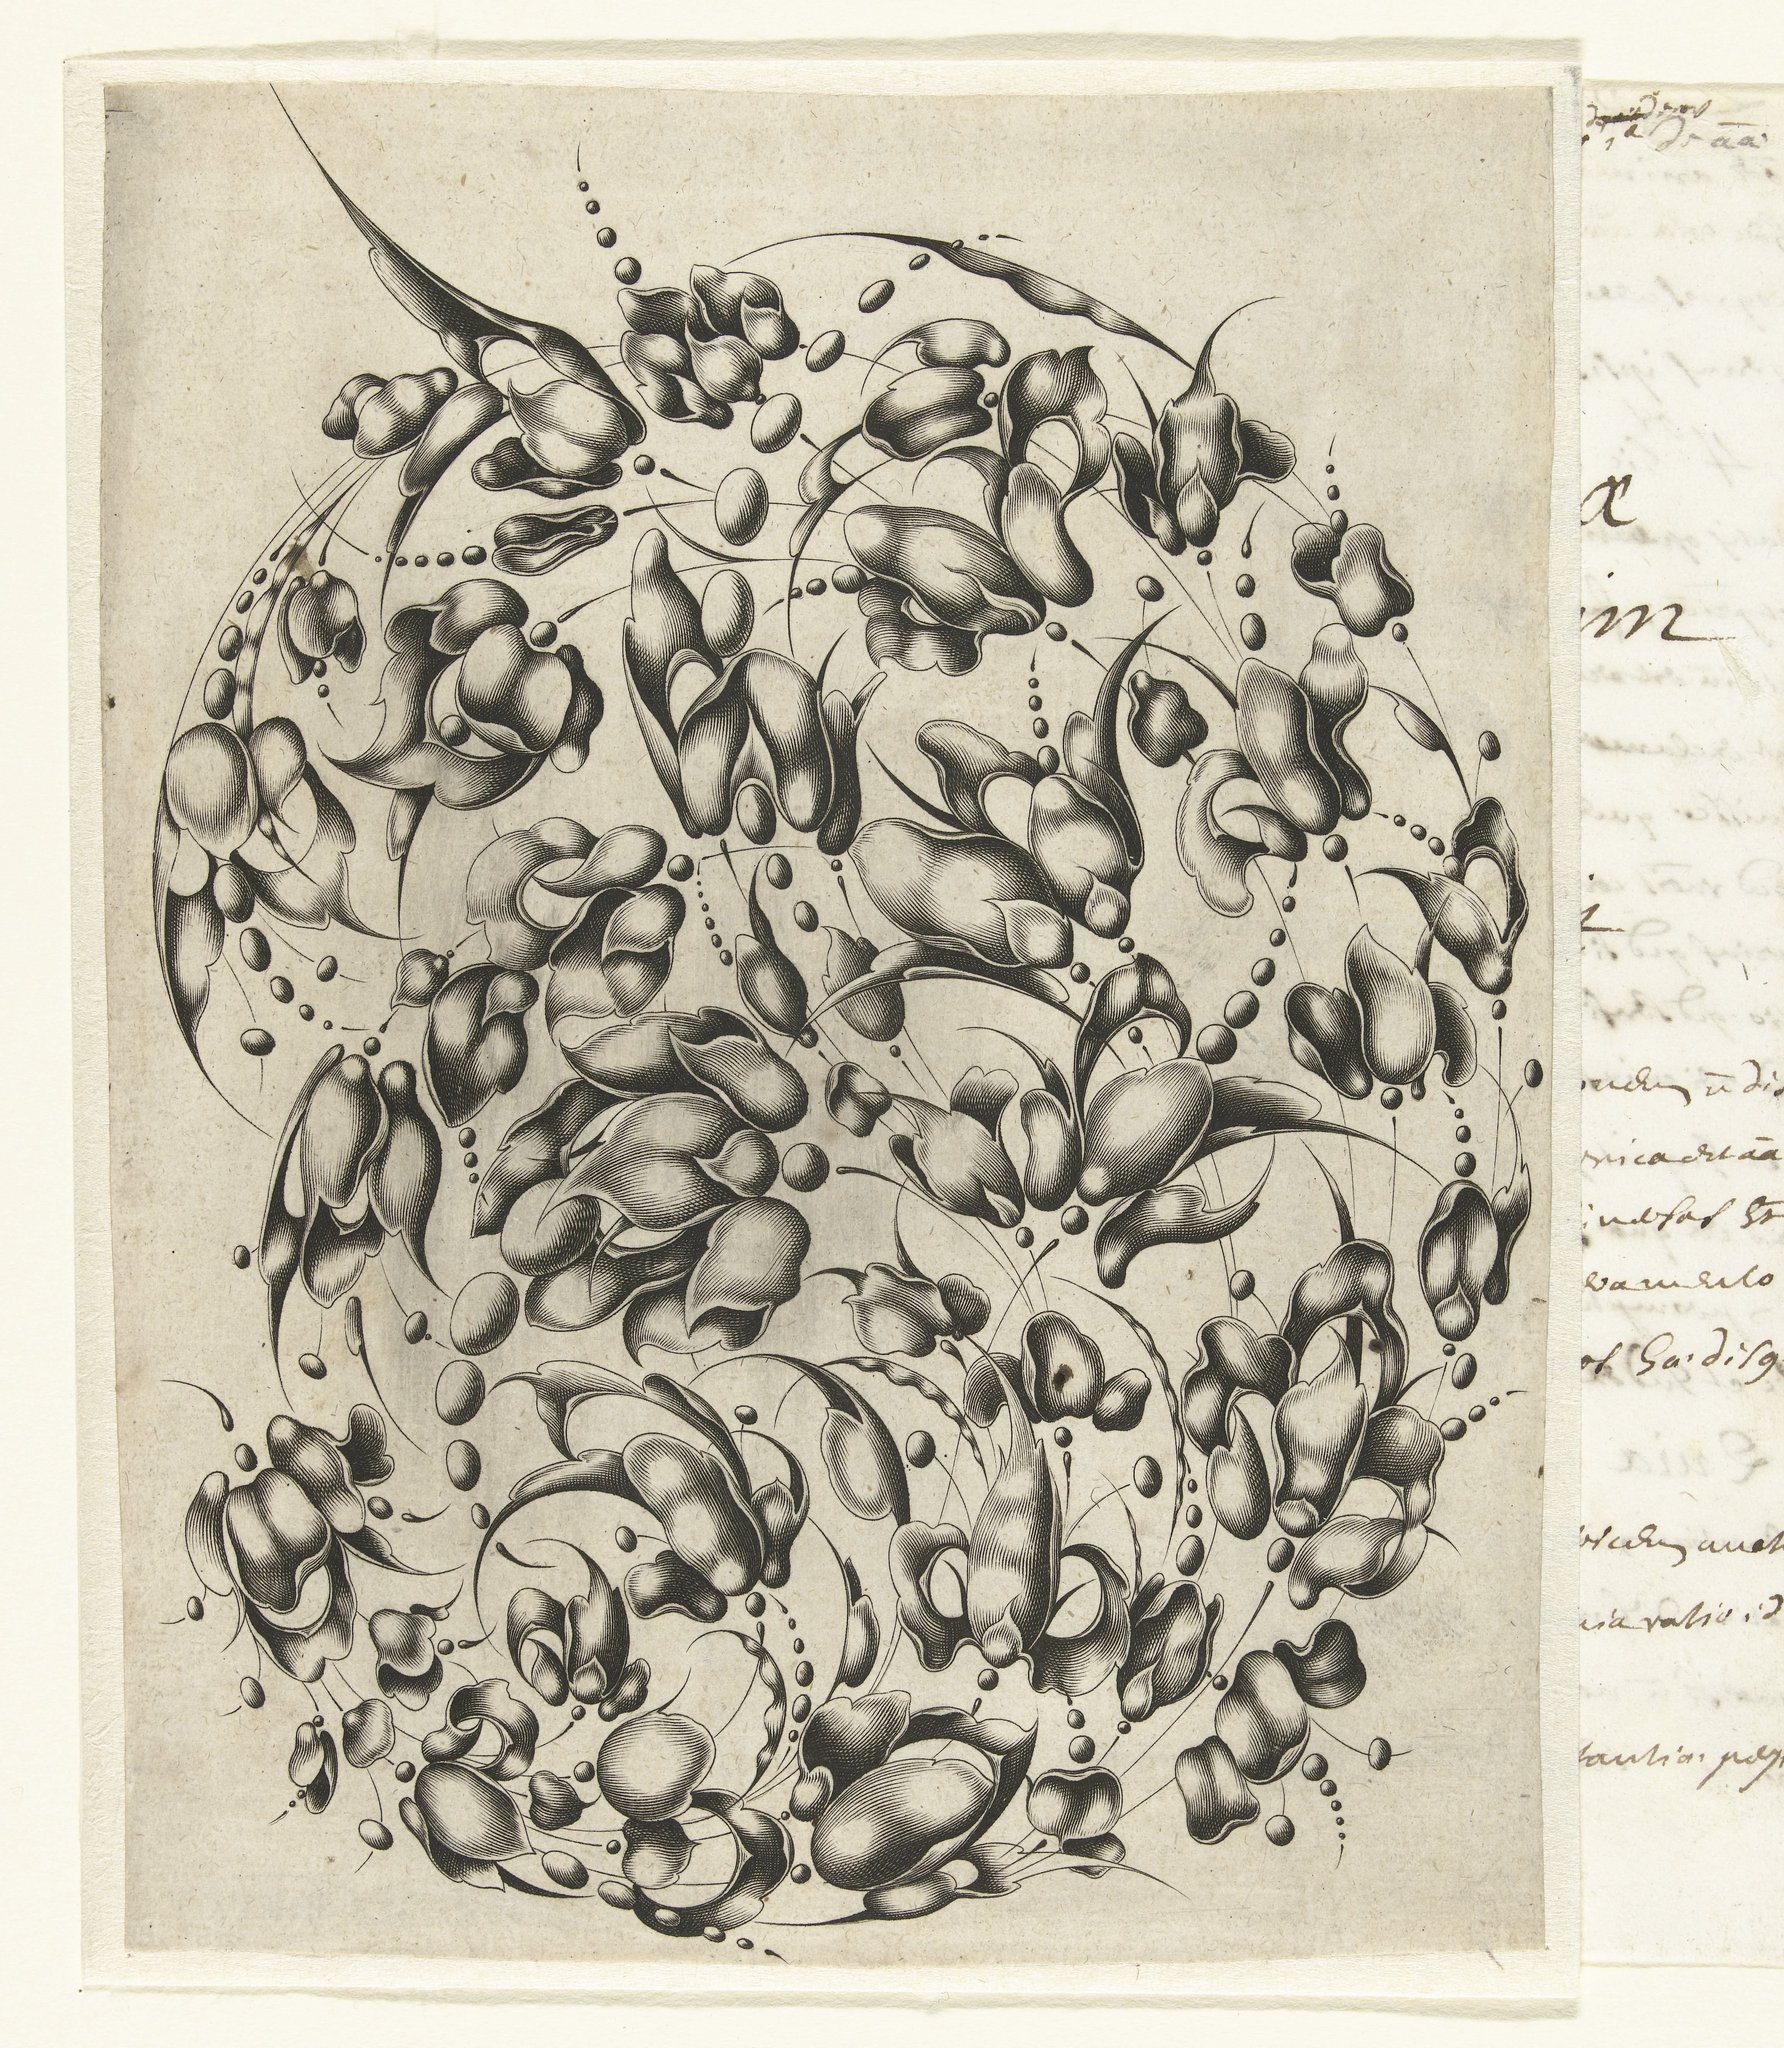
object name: ornament print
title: Goudsmidsboeket met gestileerde bloemen en bladeren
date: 1638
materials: paper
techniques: engraving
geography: amsterdam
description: Bijgevoegd is een blad met handgeschreven Latijnse tekst op de voor- en achterzijde. Uit serie van 6 bladen met tegenzijdige kopieën naar de originele serie uit 1627. Tweede editie.